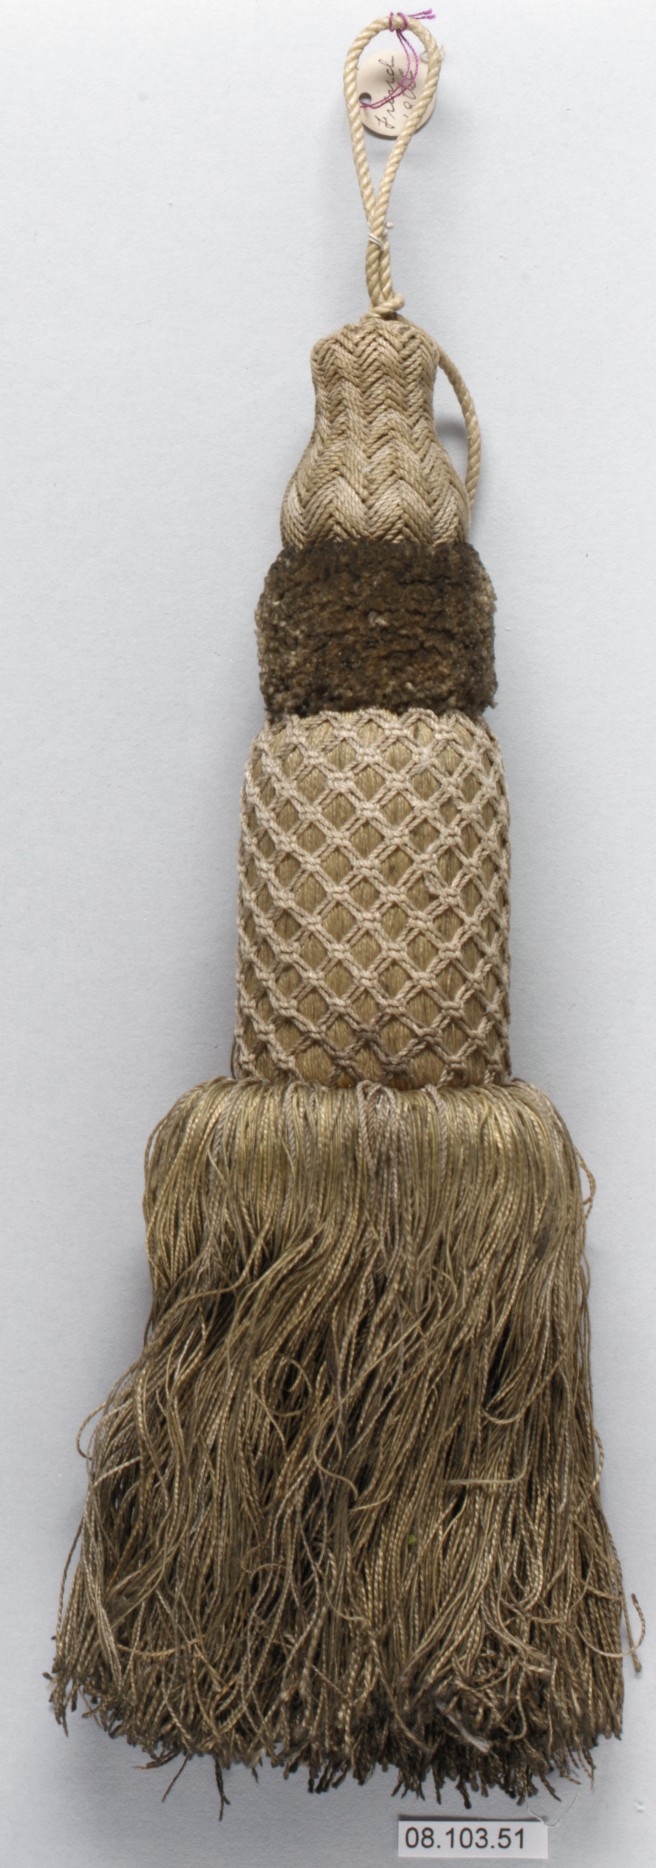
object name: tassel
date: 1801-1900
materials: silk